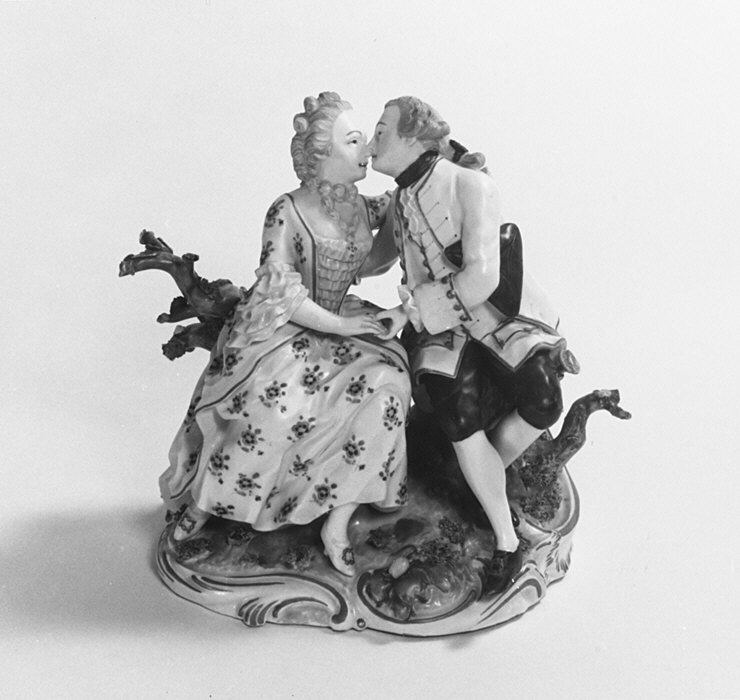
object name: group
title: Marital concord (one of a pair)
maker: frankenthal porcelain manufactory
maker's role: manufactory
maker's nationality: german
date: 1766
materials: hard paste porcelain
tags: couples,men,women